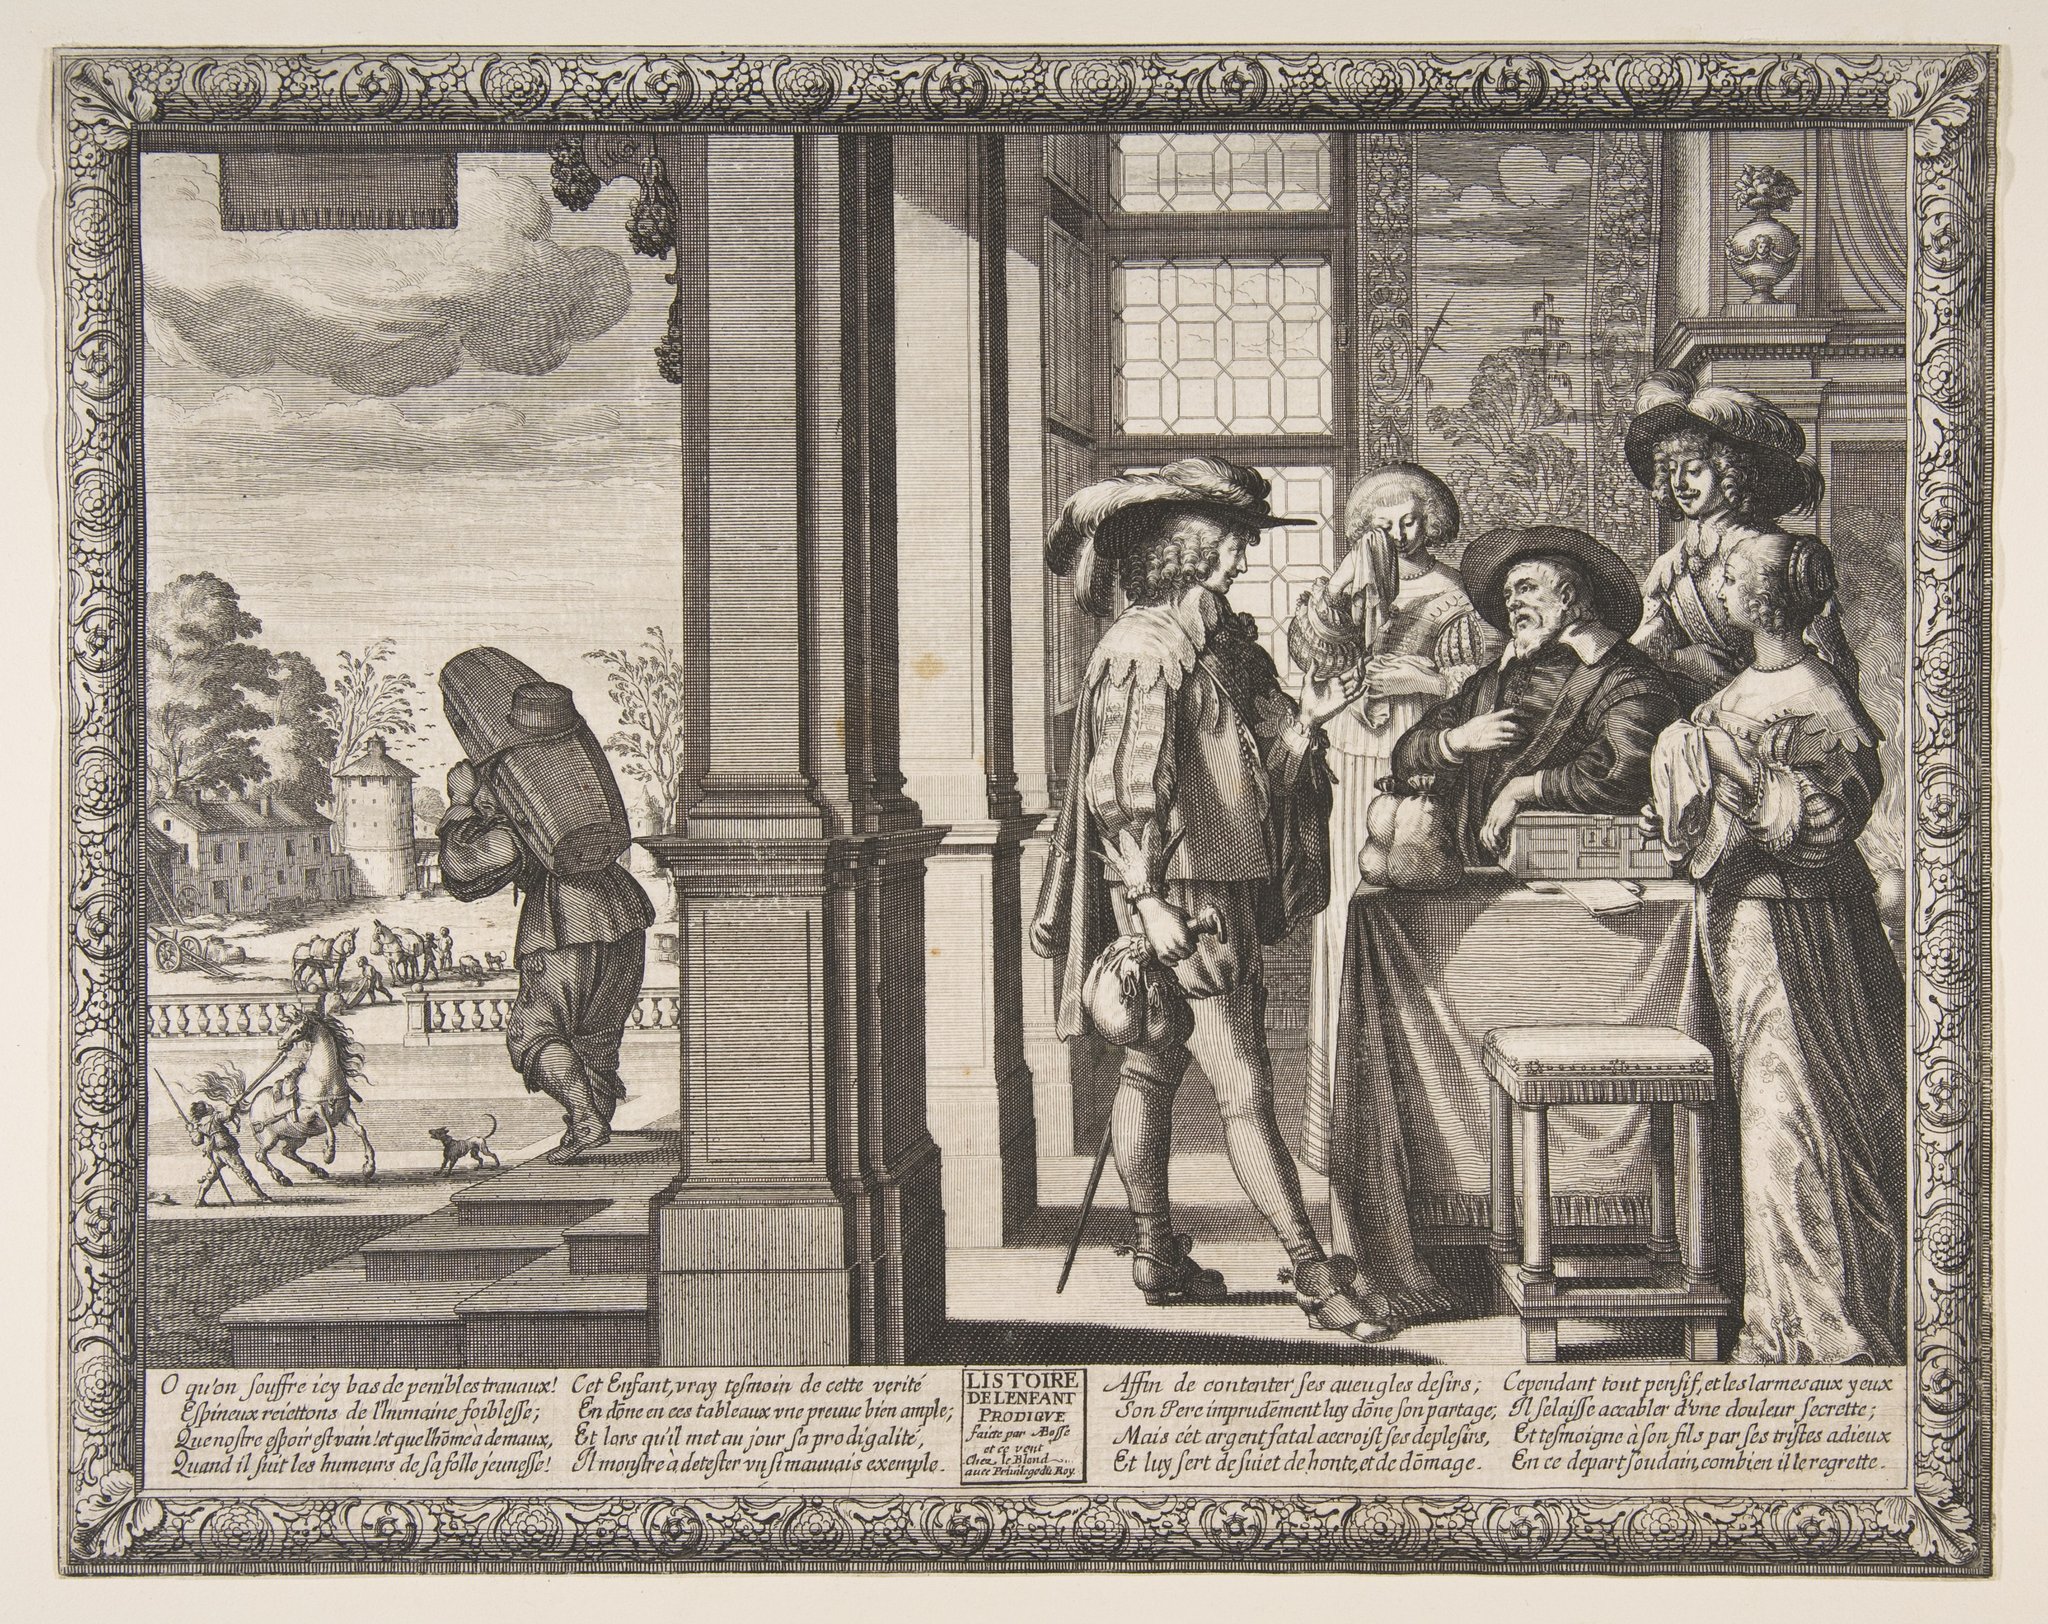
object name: print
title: The Prodigal Son Leaves Home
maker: abraham bosse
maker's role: artist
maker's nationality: french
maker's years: 1602-1676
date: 1636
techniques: etching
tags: interiors,sadness,men,women